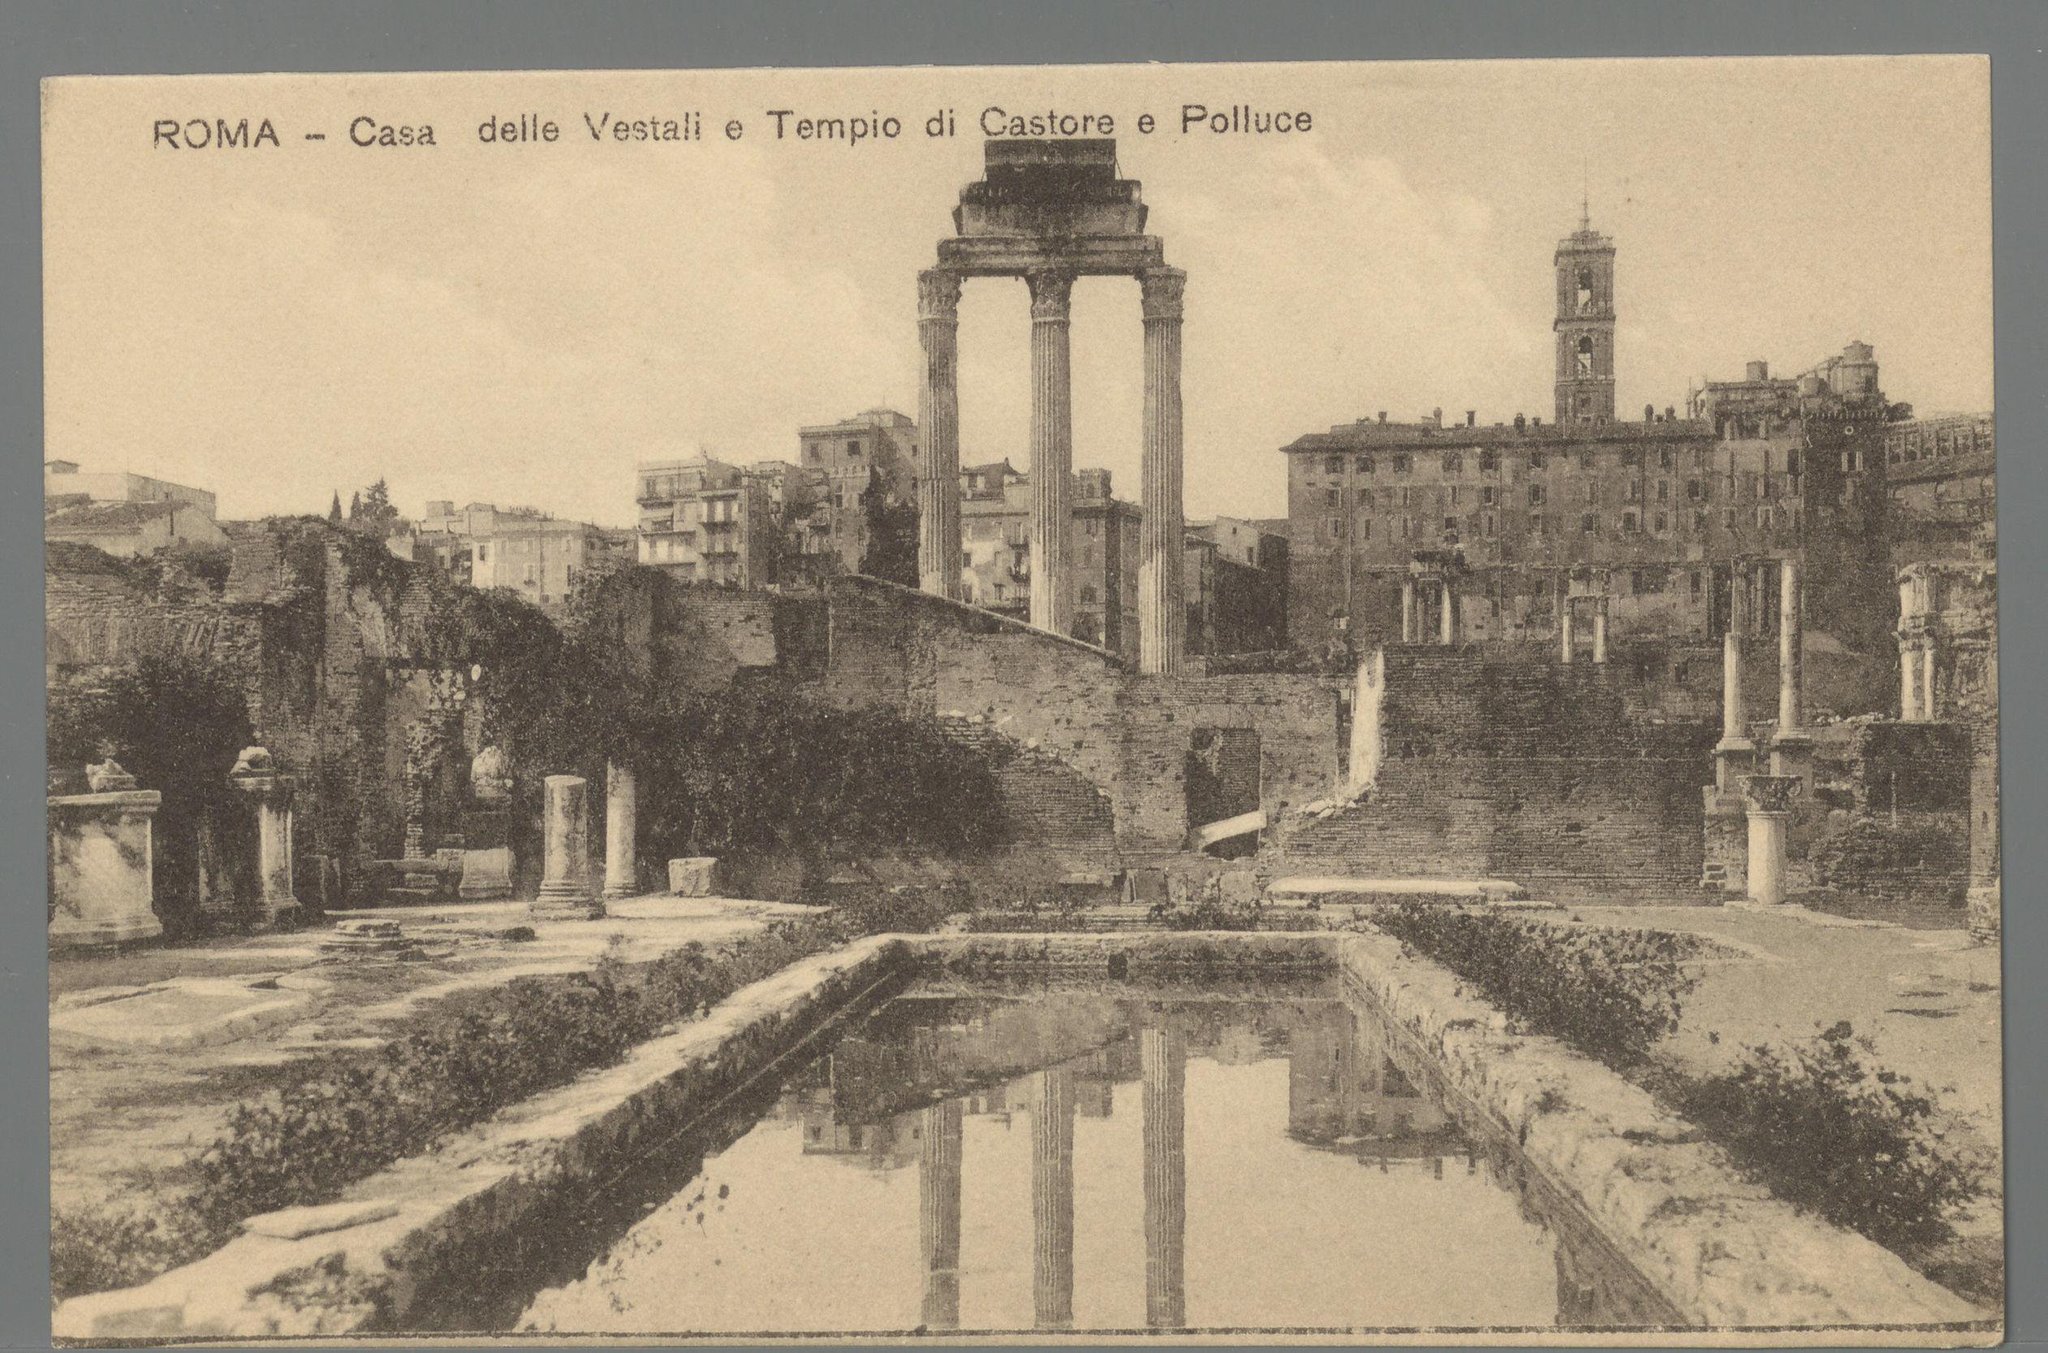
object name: photomechanical print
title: Roma. Casa delle Vestali e Tempio di Castore e Polluce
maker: Anonymous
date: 1906-1920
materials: cardboard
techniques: photograph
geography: rome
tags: city-view, and landscape with man-made constructions, temple, shrine ~ roman religion, excavation ~ archaeology